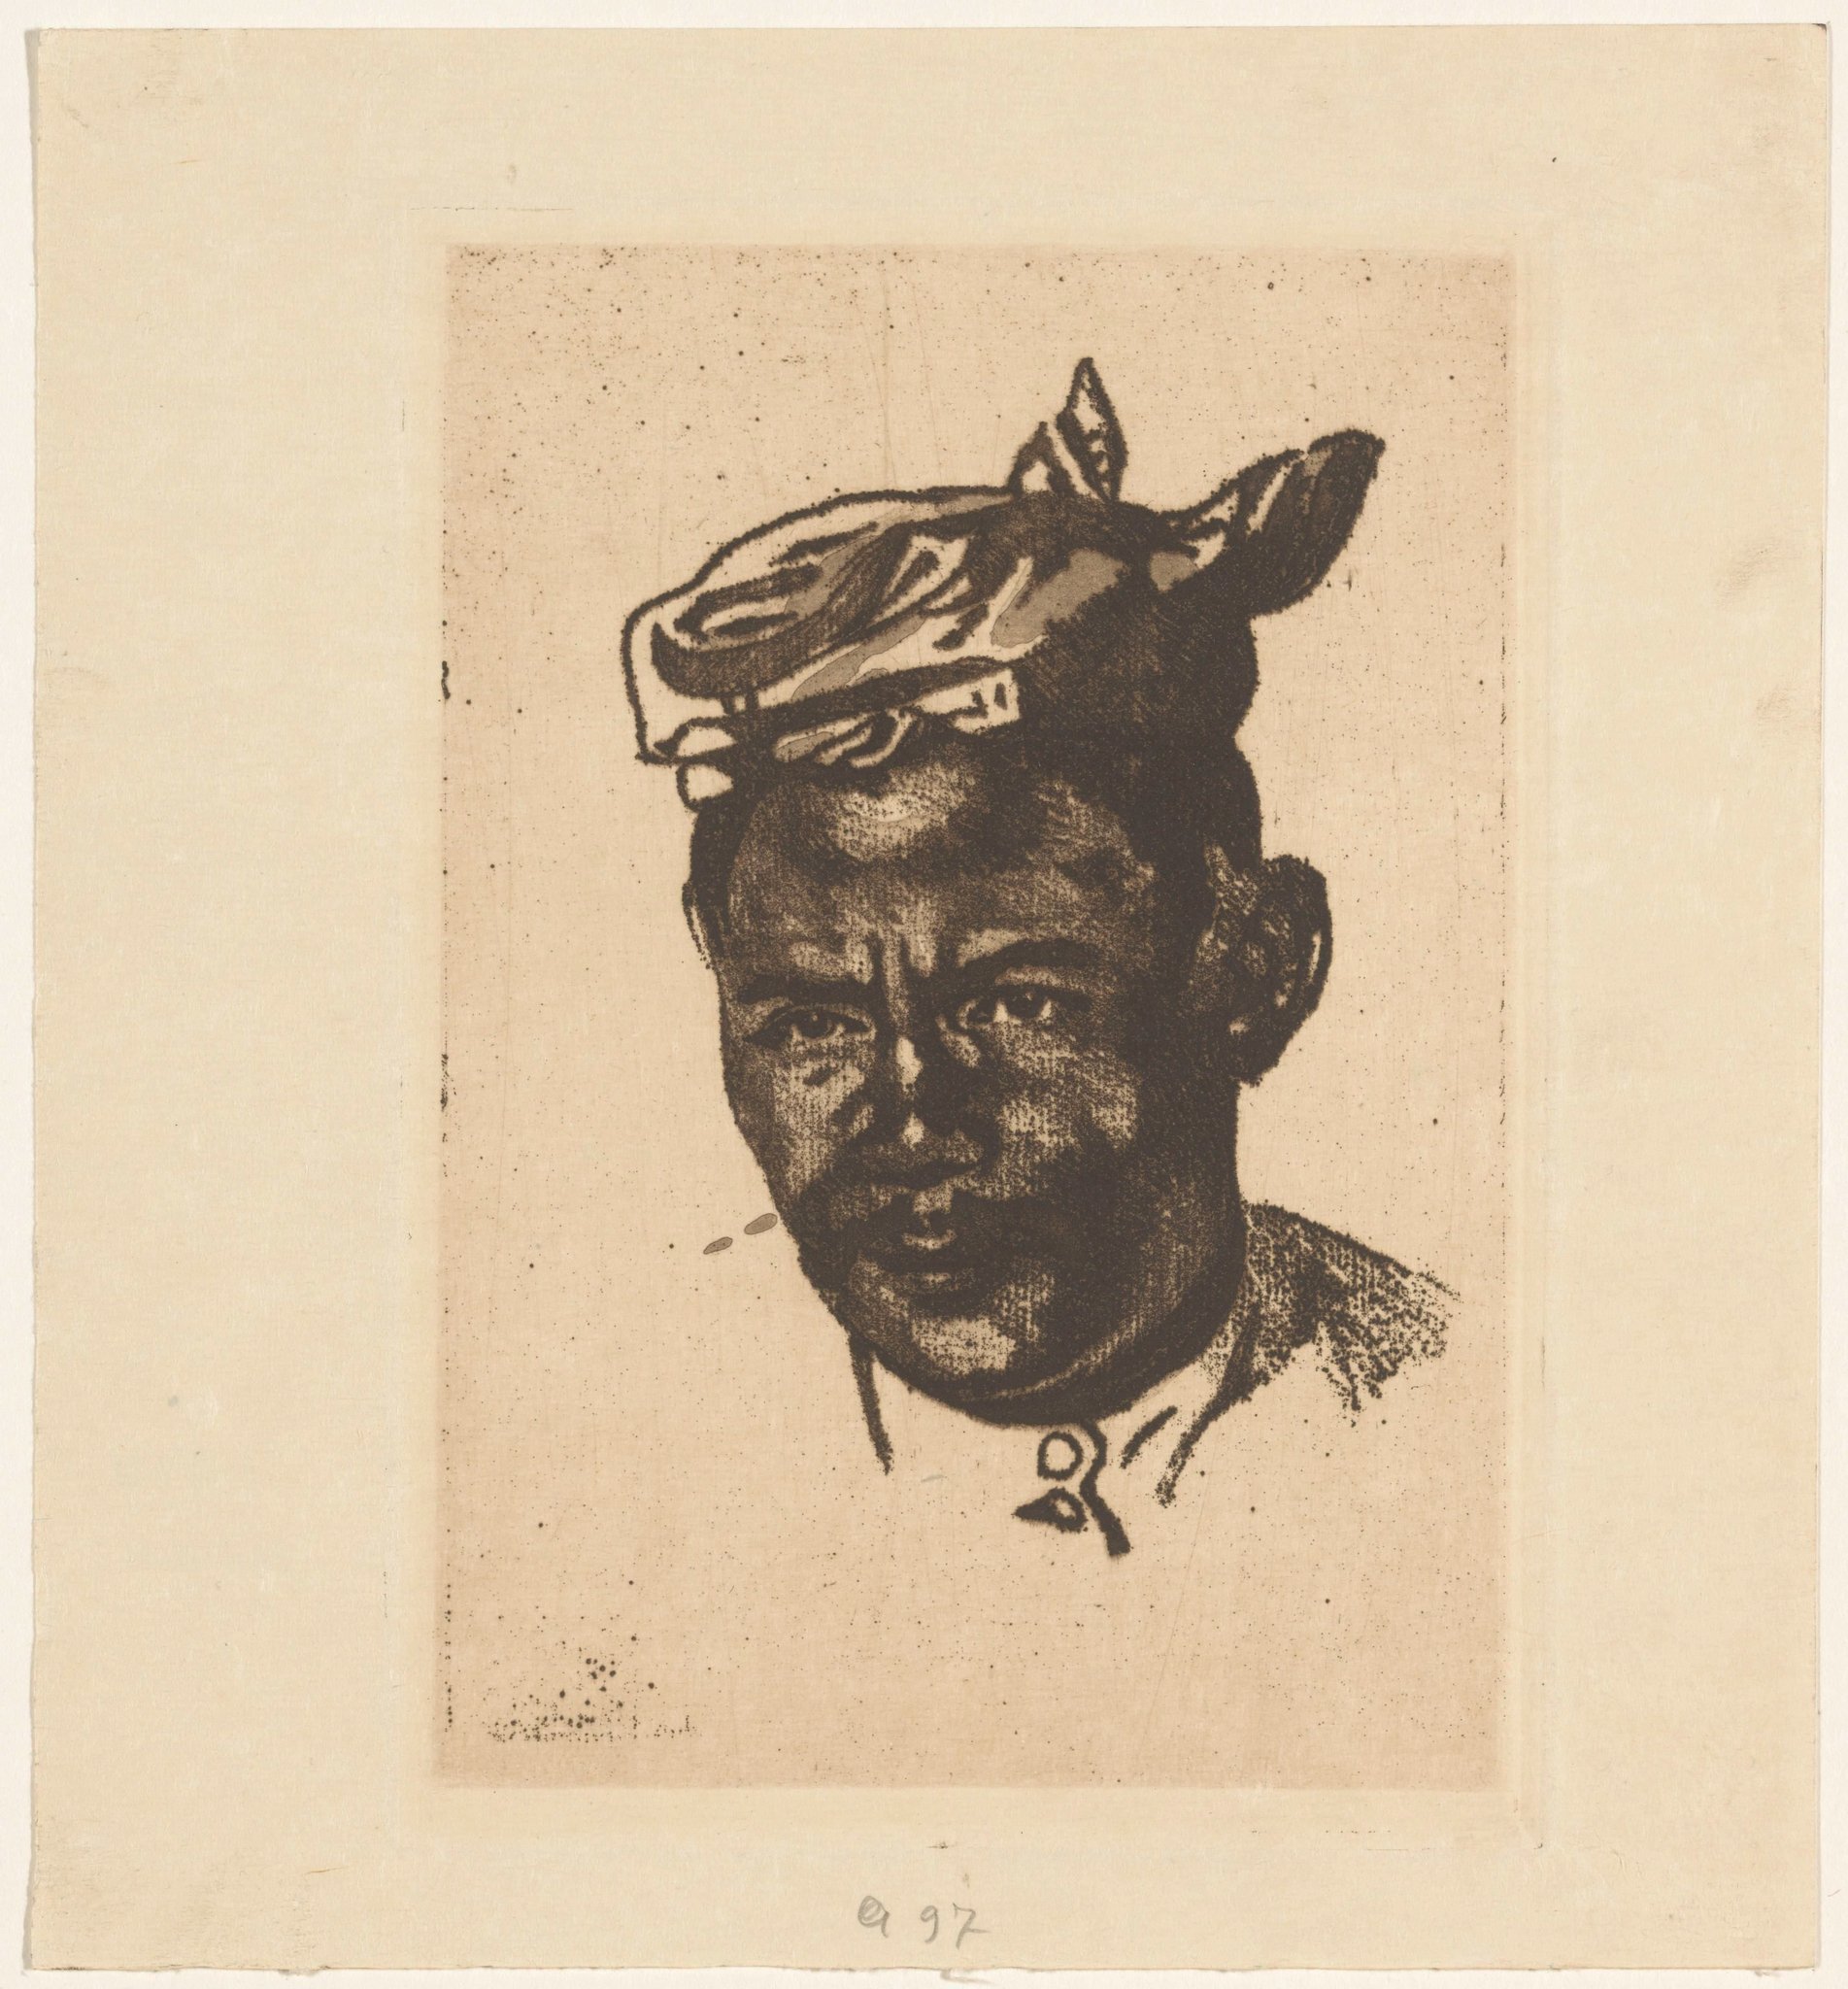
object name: print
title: Portret van Amit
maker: willem witsen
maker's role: draughtsman, painter, print maker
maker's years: 1860-1923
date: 1921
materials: paper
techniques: aquatint, intaglio, soft ground etching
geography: amsterdam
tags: head-gear, historical persons (portraits and scenes from the life)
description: Amit was een kamerjongen in Hotel Bellevue, waar Willem Witsen verbleef toen hij in Buitenzorg was.